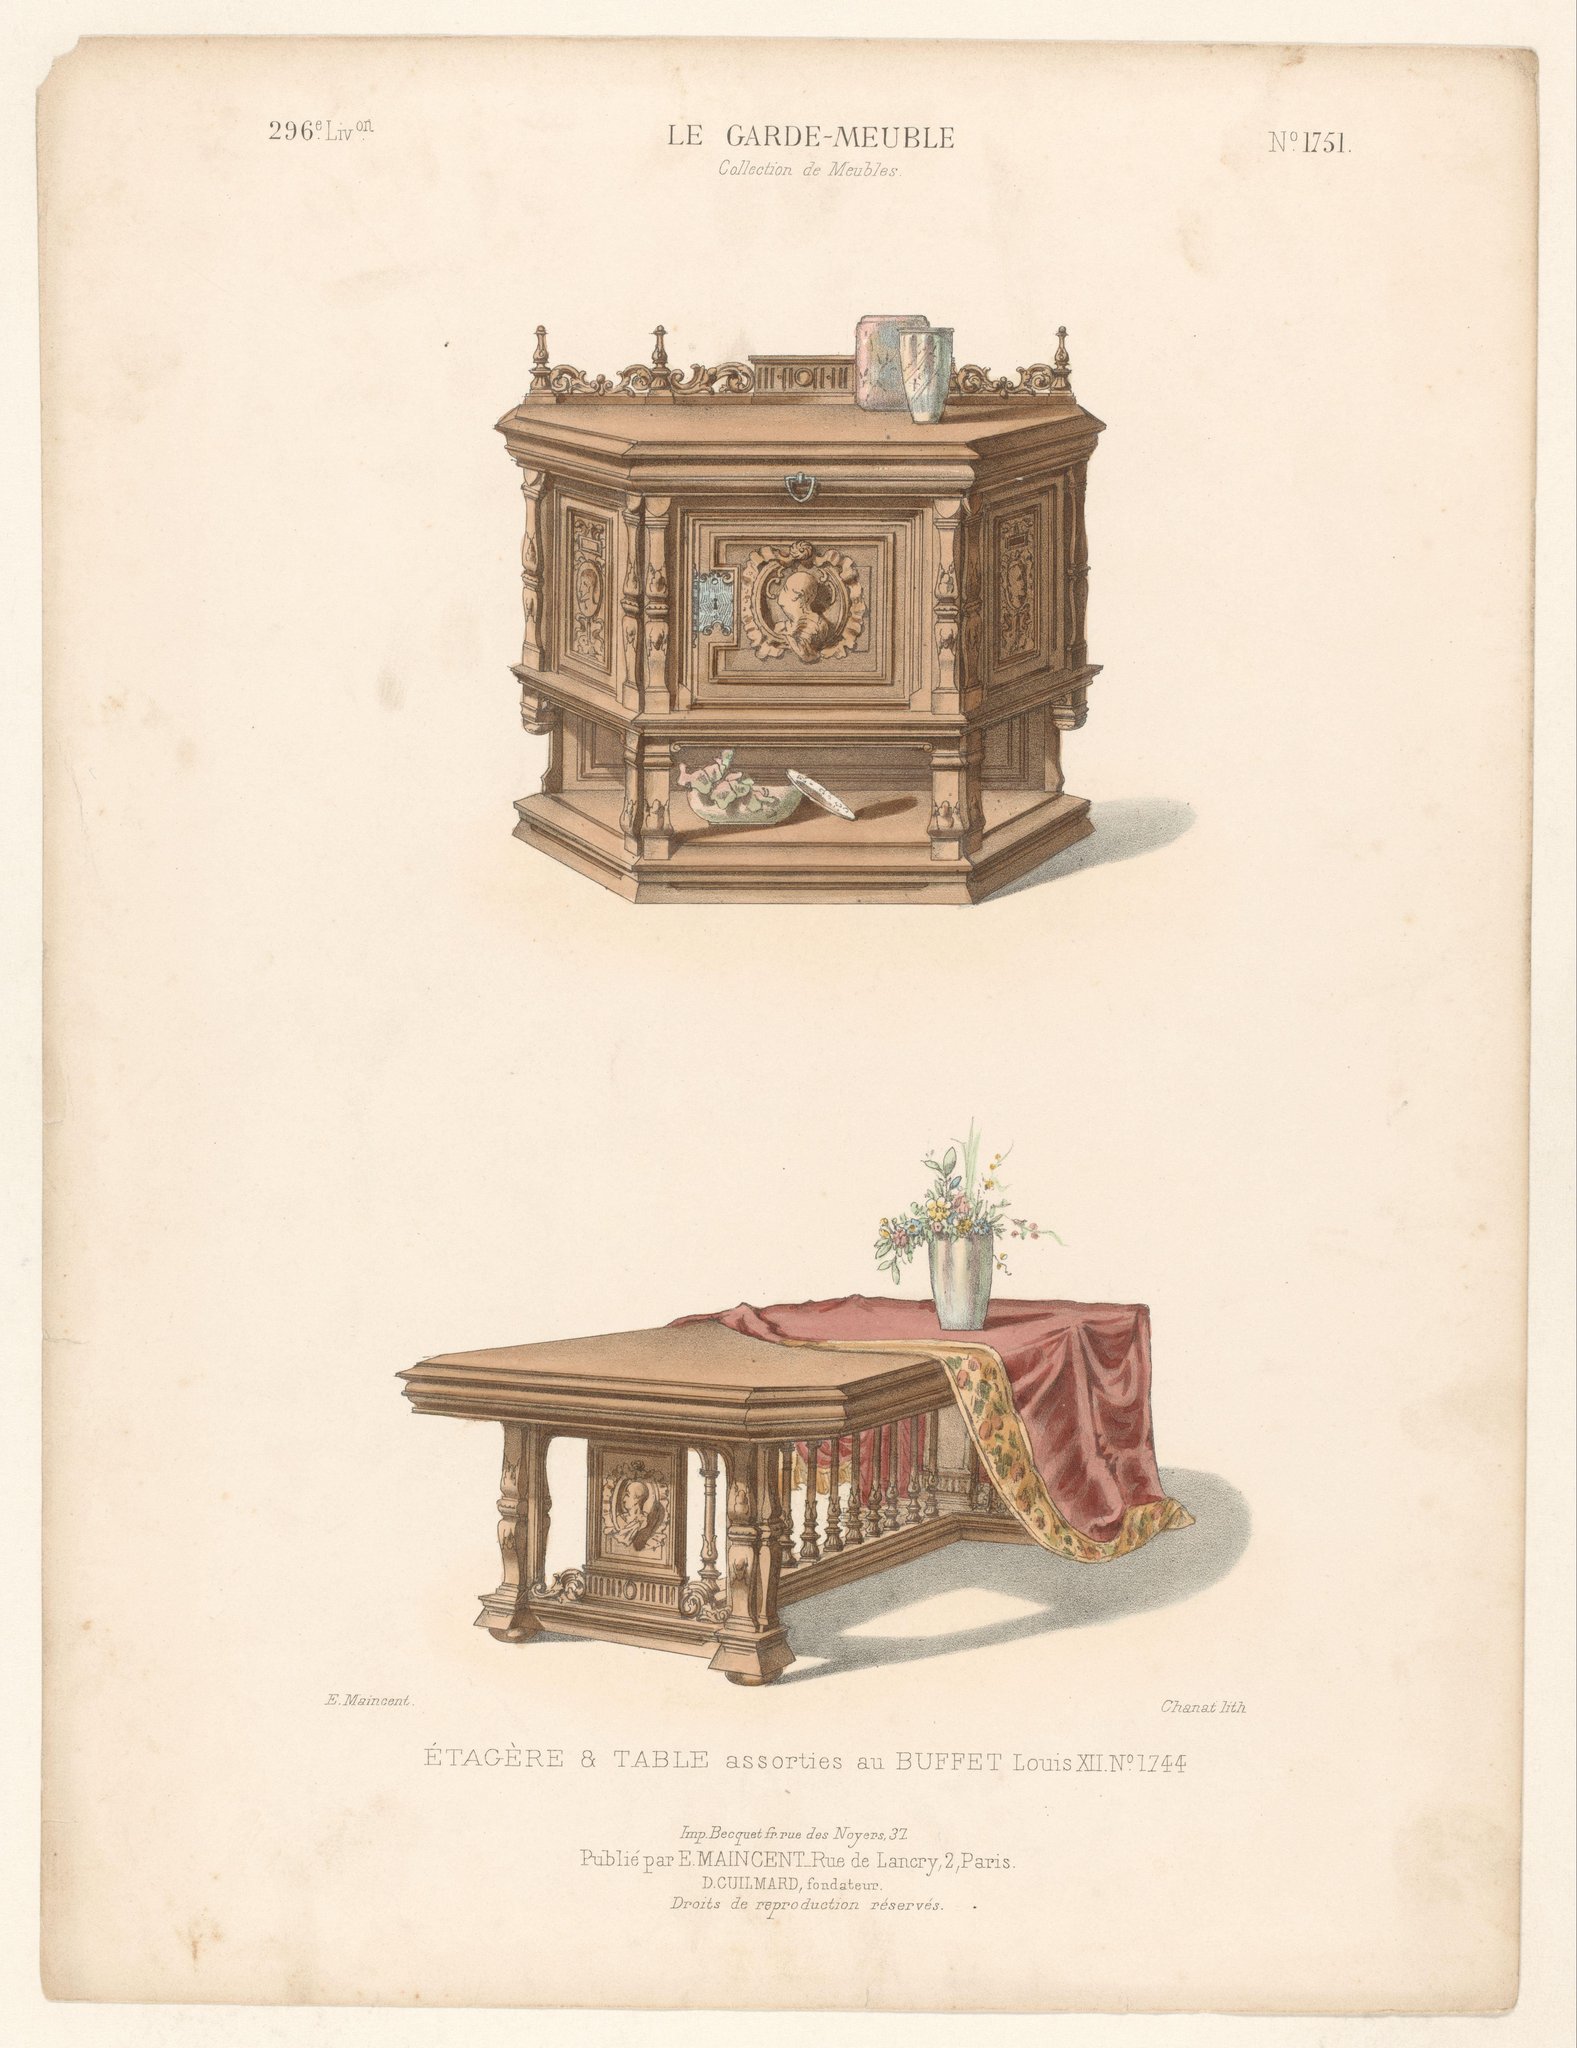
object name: print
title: Kast en tafel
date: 1885-1895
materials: paper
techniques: hand coloring, lithograph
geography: paris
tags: furniture for storage, table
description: Ieder Livraison in de serie Le Garde-Meuble bevat negen platen: drie 'sièges' (zitmeubels), drie 'meubles' (diverse meubels zoals tafels en kasten) en drie 'tentures' (gordijnen en draperieën).